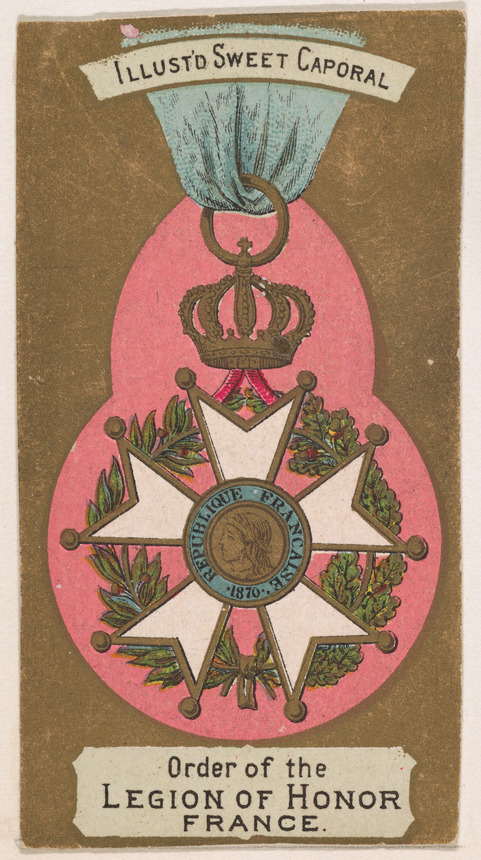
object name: print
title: Order of the Legion of Honor, France, from the Military Series (N224) issued by Kinney Tobacco Company to promote Sweet Caporal Cigarettes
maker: kinney brothers tobacco company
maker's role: publisher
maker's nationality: american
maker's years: 1869-2011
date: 1888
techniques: color lithograph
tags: profiles,women